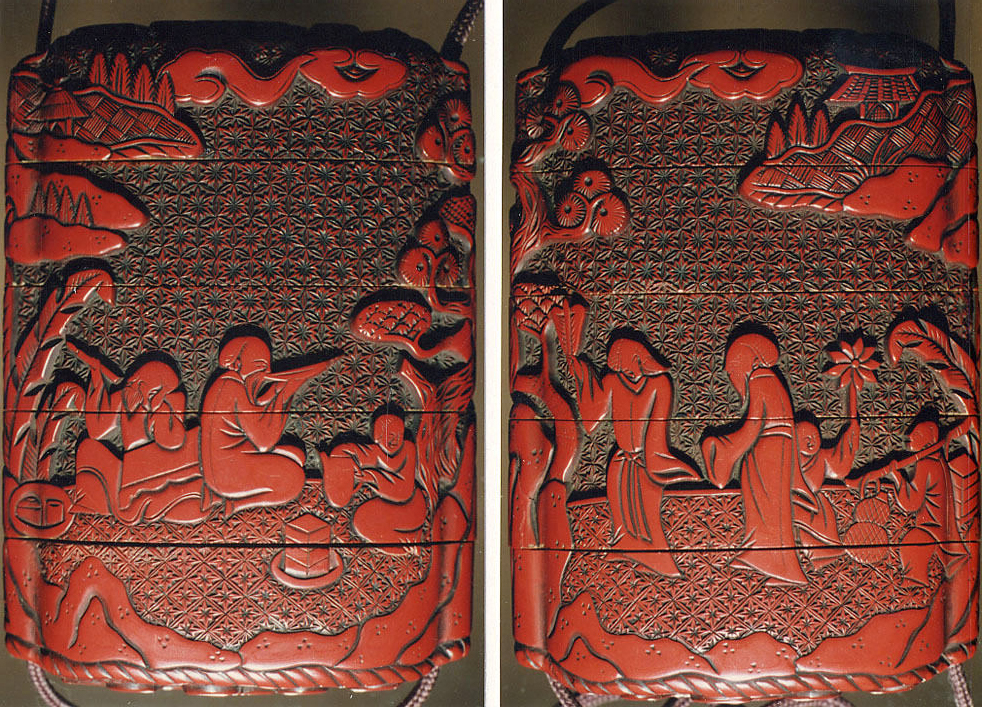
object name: inrō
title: Case (Inrō) with Design of Chinese Sages Drinking and Writing on Banana Leaf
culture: japanese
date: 1701-1900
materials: lacquer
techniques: carving, fundame, relief, stain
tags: human figures,drinking